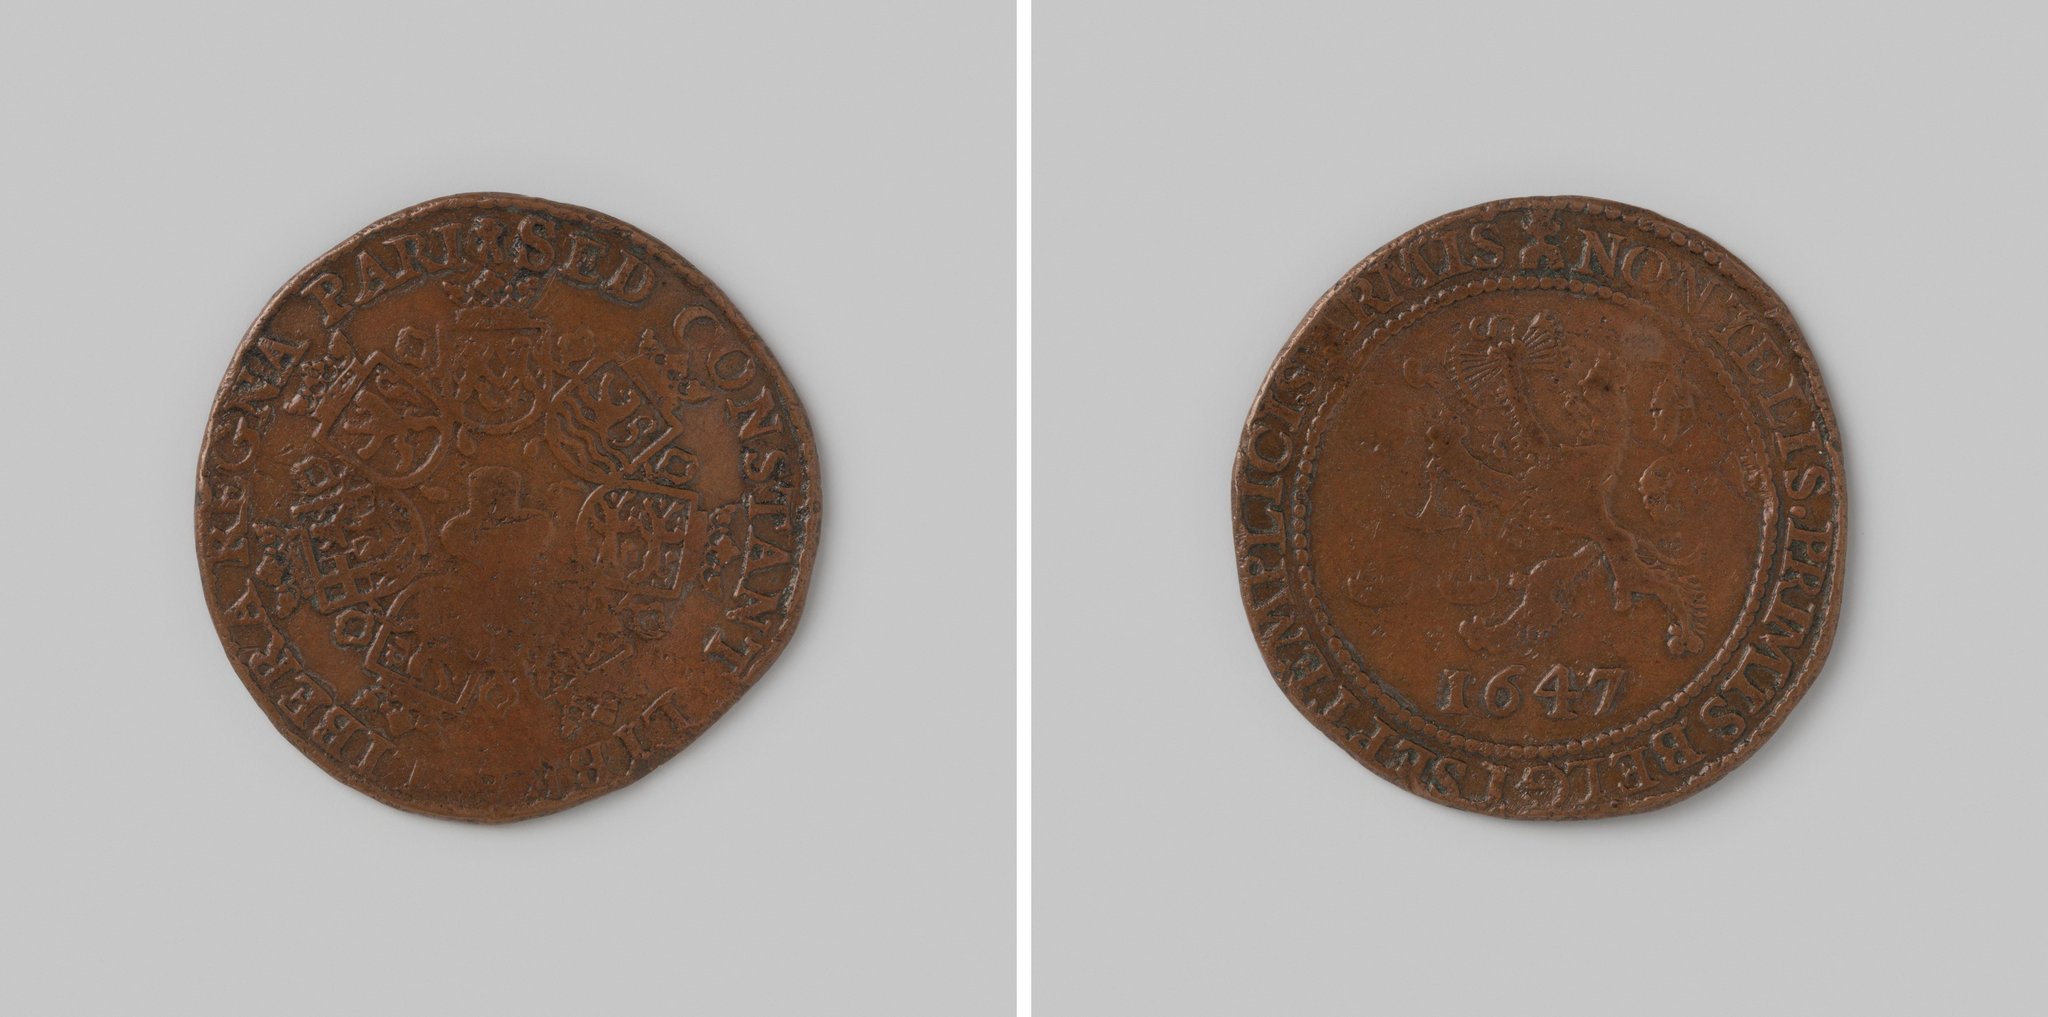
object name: jeton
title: Rekenpenning uit Middelburg op de vredesonderhandelingen met Spanje 1647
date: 1647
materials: copper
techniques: striking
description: Koperen penning, op de voorzijde rond een vrijheidshoed zeven gekroonde provinciale wapenschilden verbonden door een koord, met omschrift, op de keerzijde een klimmende leeuw naar links met pijlenbundel en weegschaal, met omschrift.